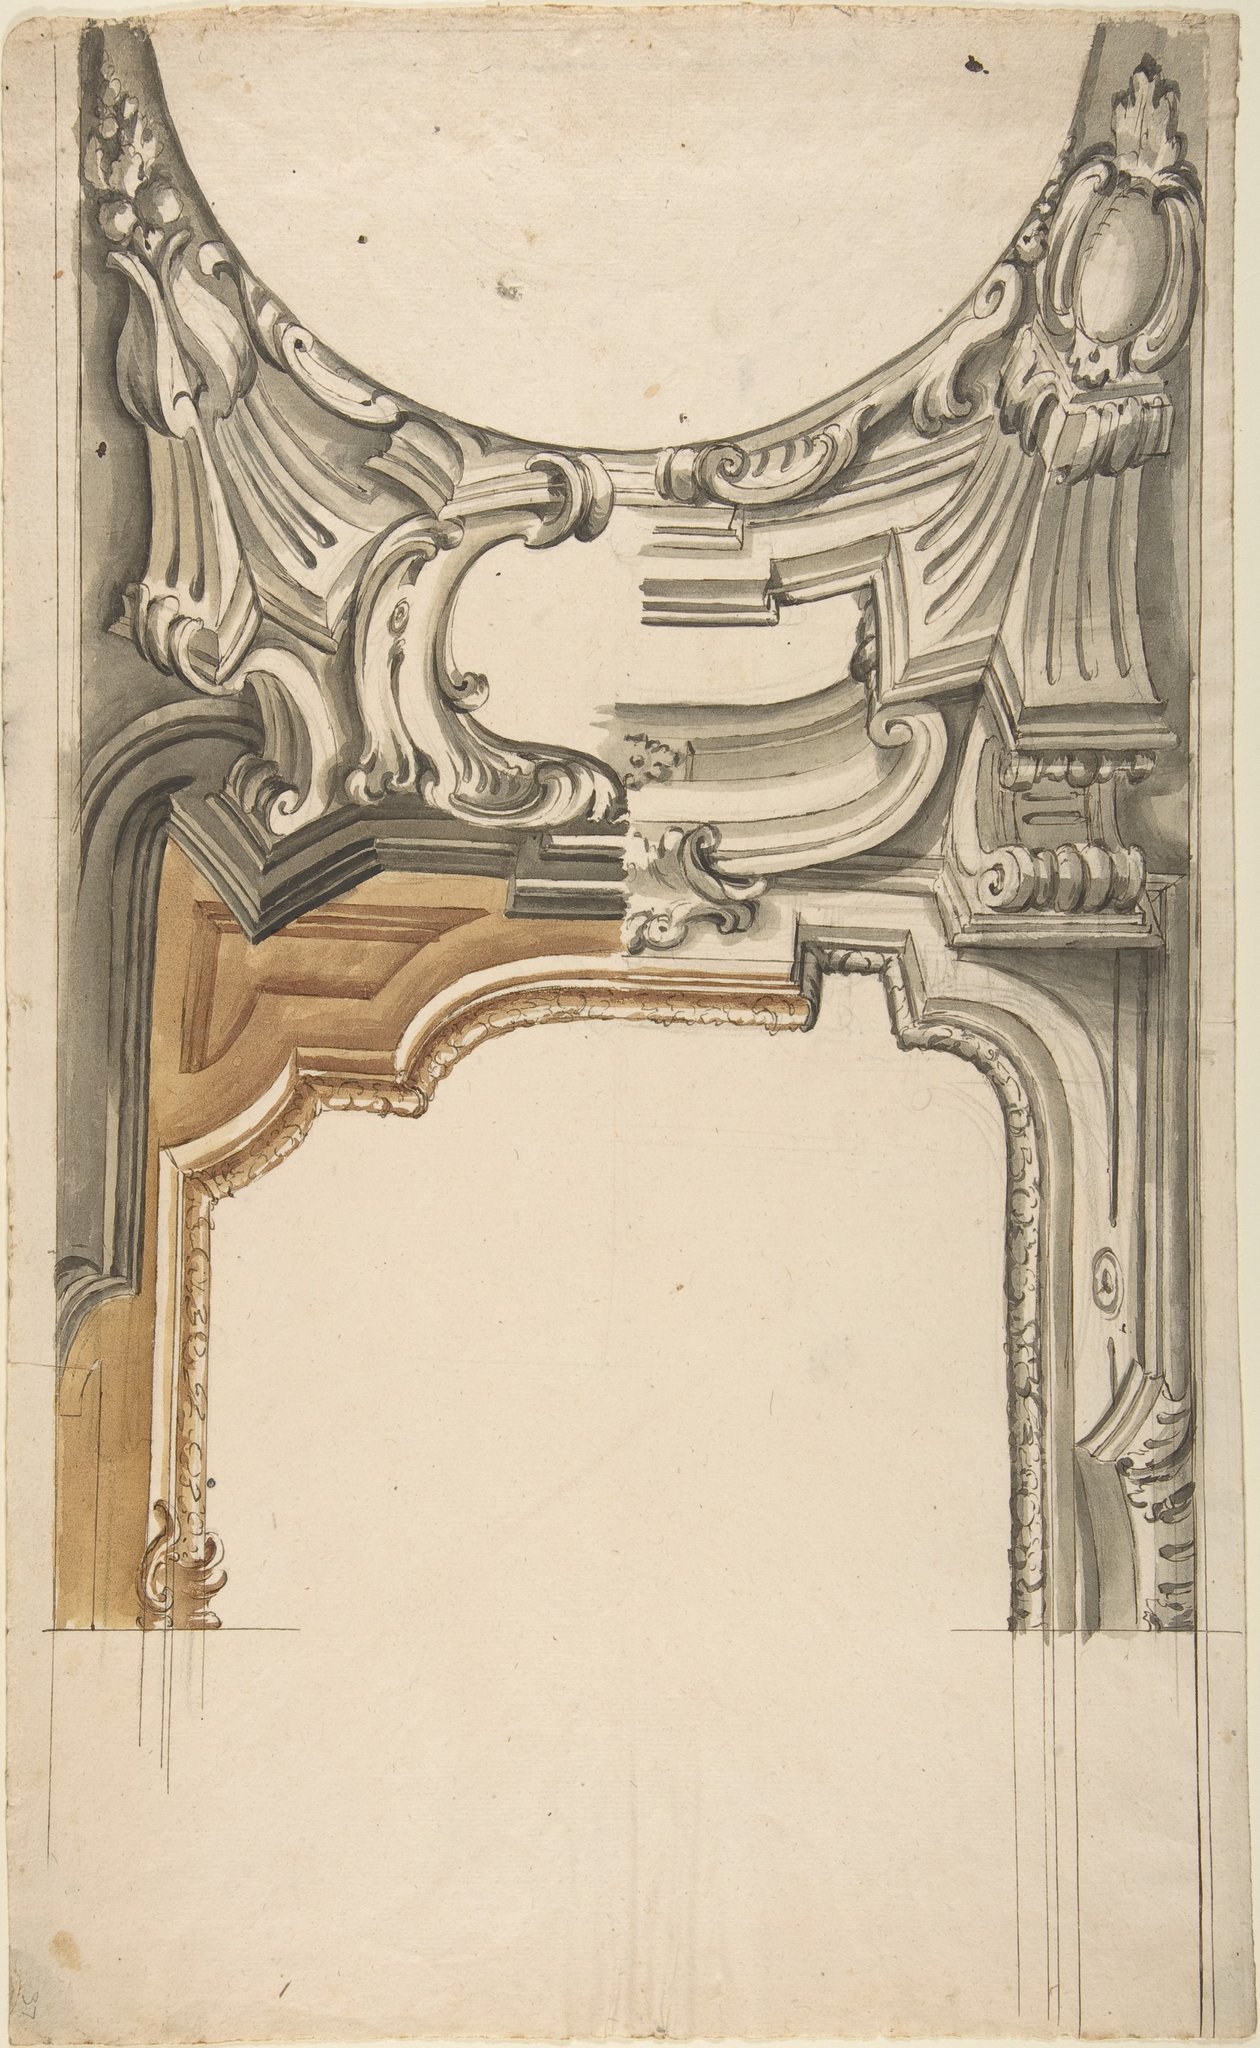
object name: drawing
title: Two Alternate Designs for a Decoration over an Arched Opening with an Ornamental Cove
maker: anonymous, italian, piedmontese, 18th century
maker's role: artist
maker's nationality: italian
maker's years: 1700-1800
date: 1700-1780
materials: ink, drawing material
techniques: brush, pen, wash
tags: ornament